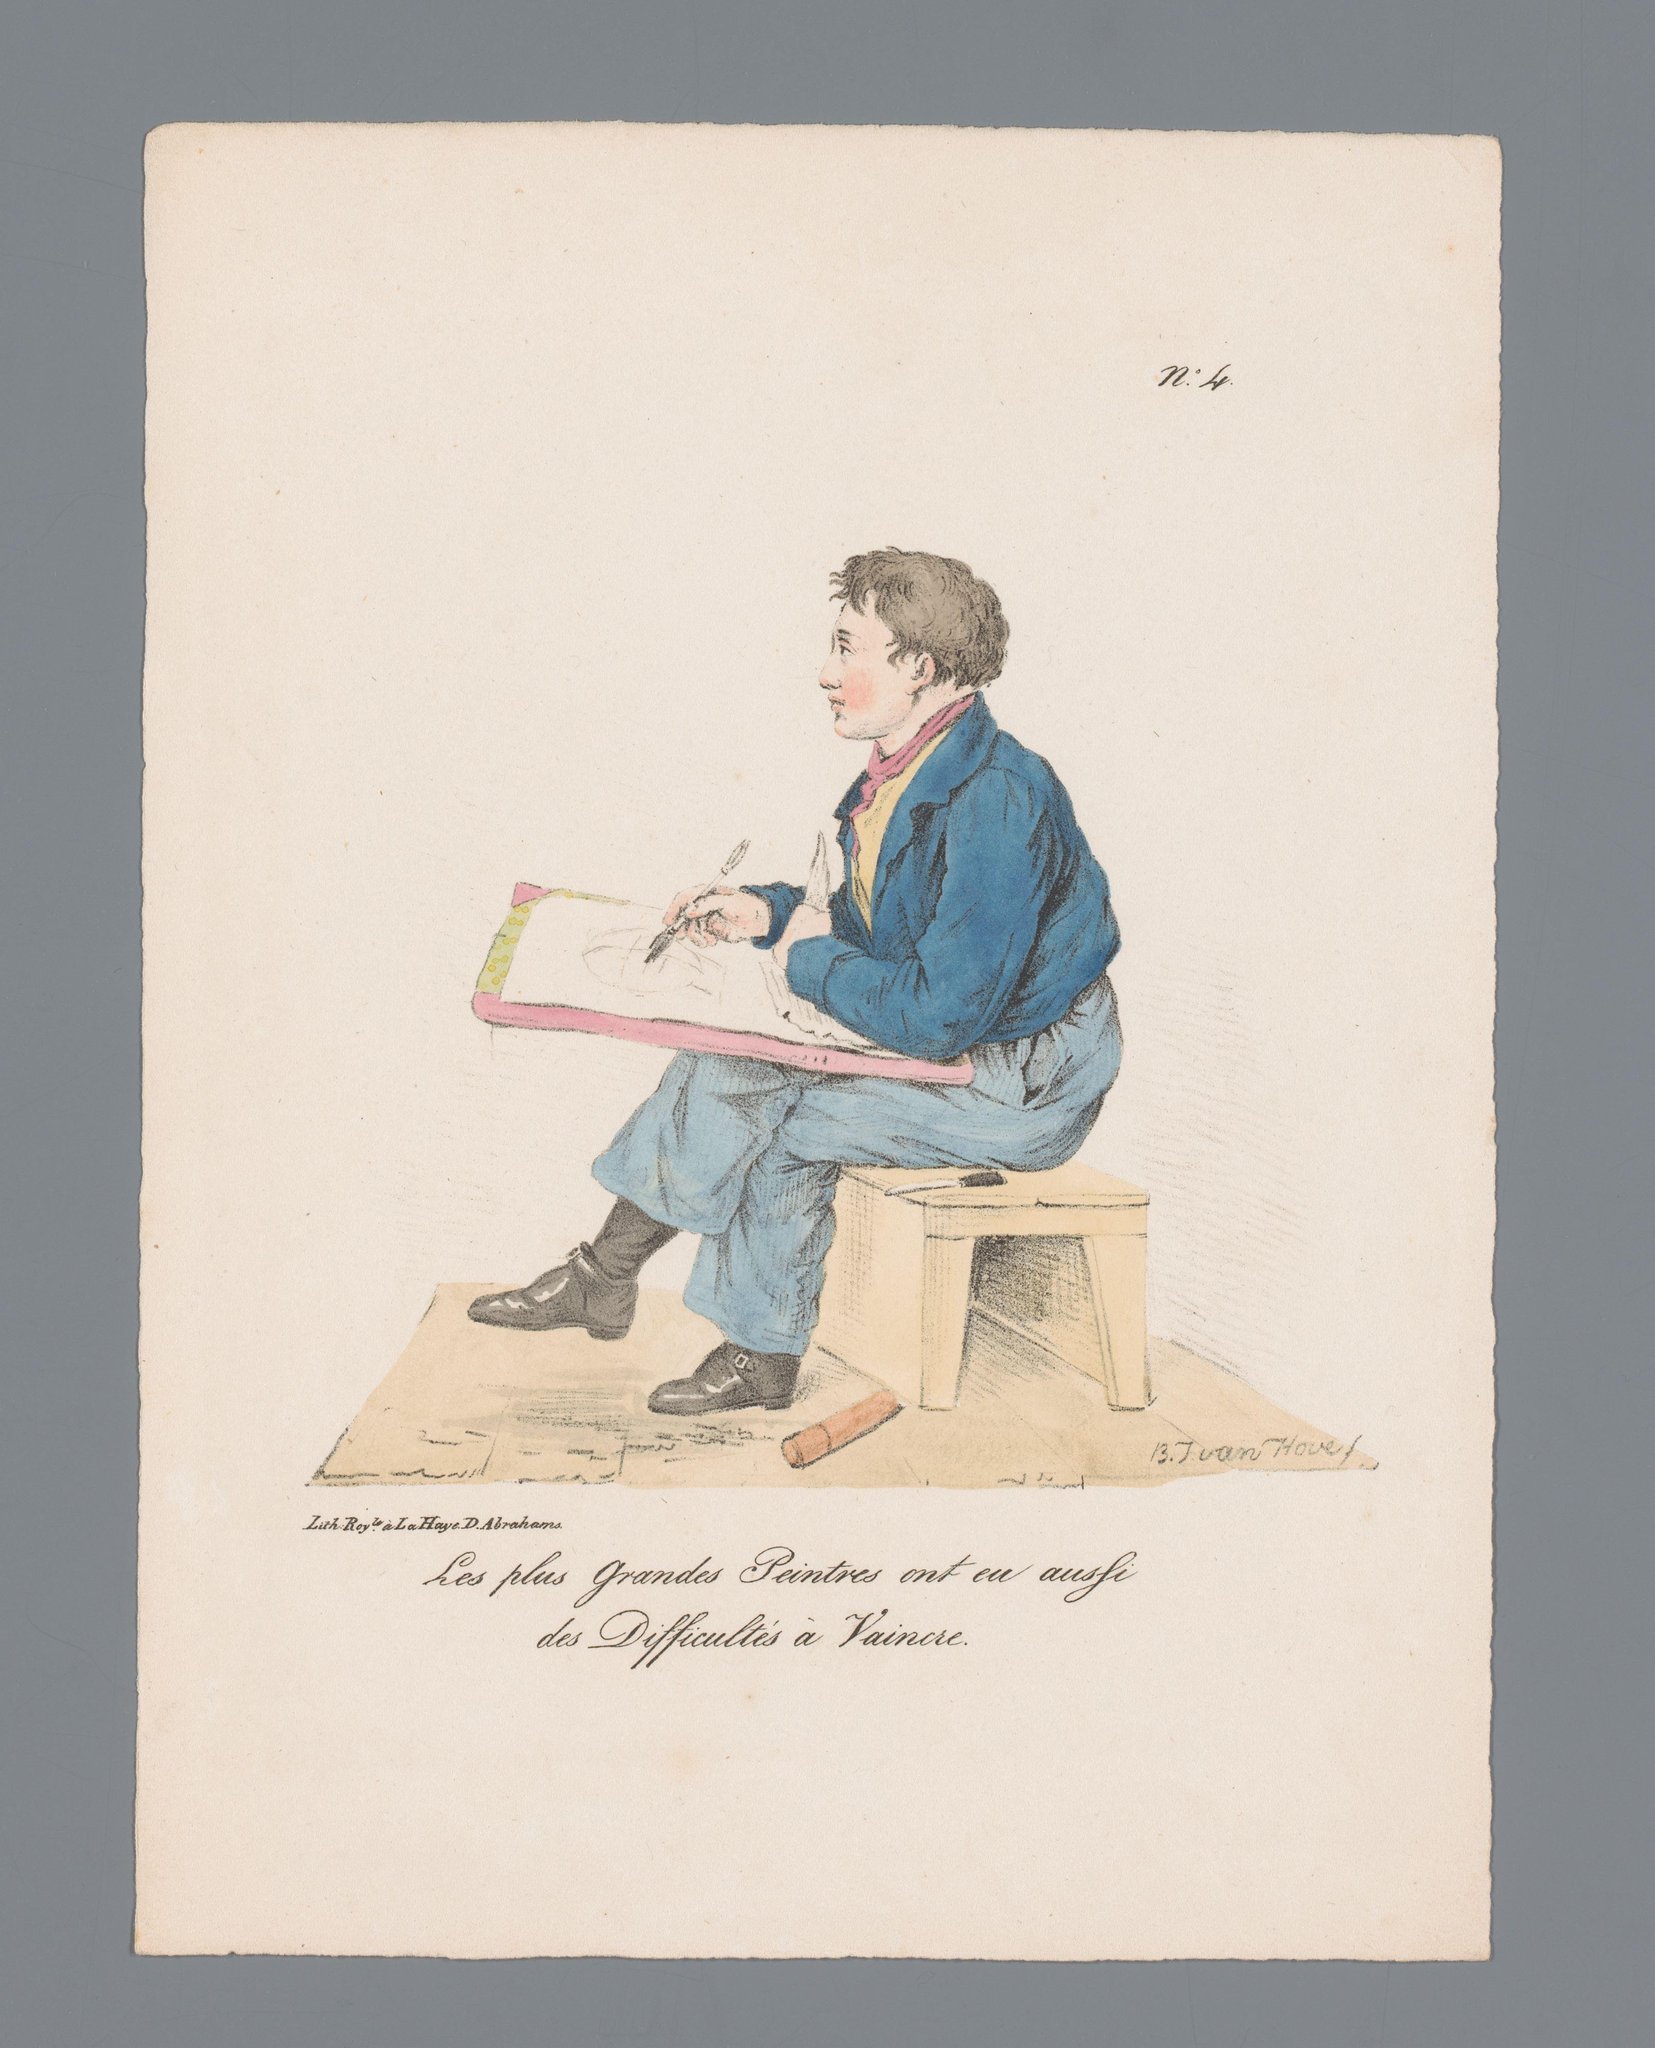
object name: print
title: Jongen met tekening op schoot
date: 1824-1825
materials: paper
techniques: hand coloring, lithograph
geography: netherlands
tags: drawing, youth, adolescent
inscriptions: collector's mark: Lugt 2228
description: De jongen heeft een map op schoot met daarop een tekening waaraan hij werkt. Hij kijkt voor zich. Genummerd rechtsboven: No. 4. De prent maakt deel uit van een omslag met vier losse prenten.